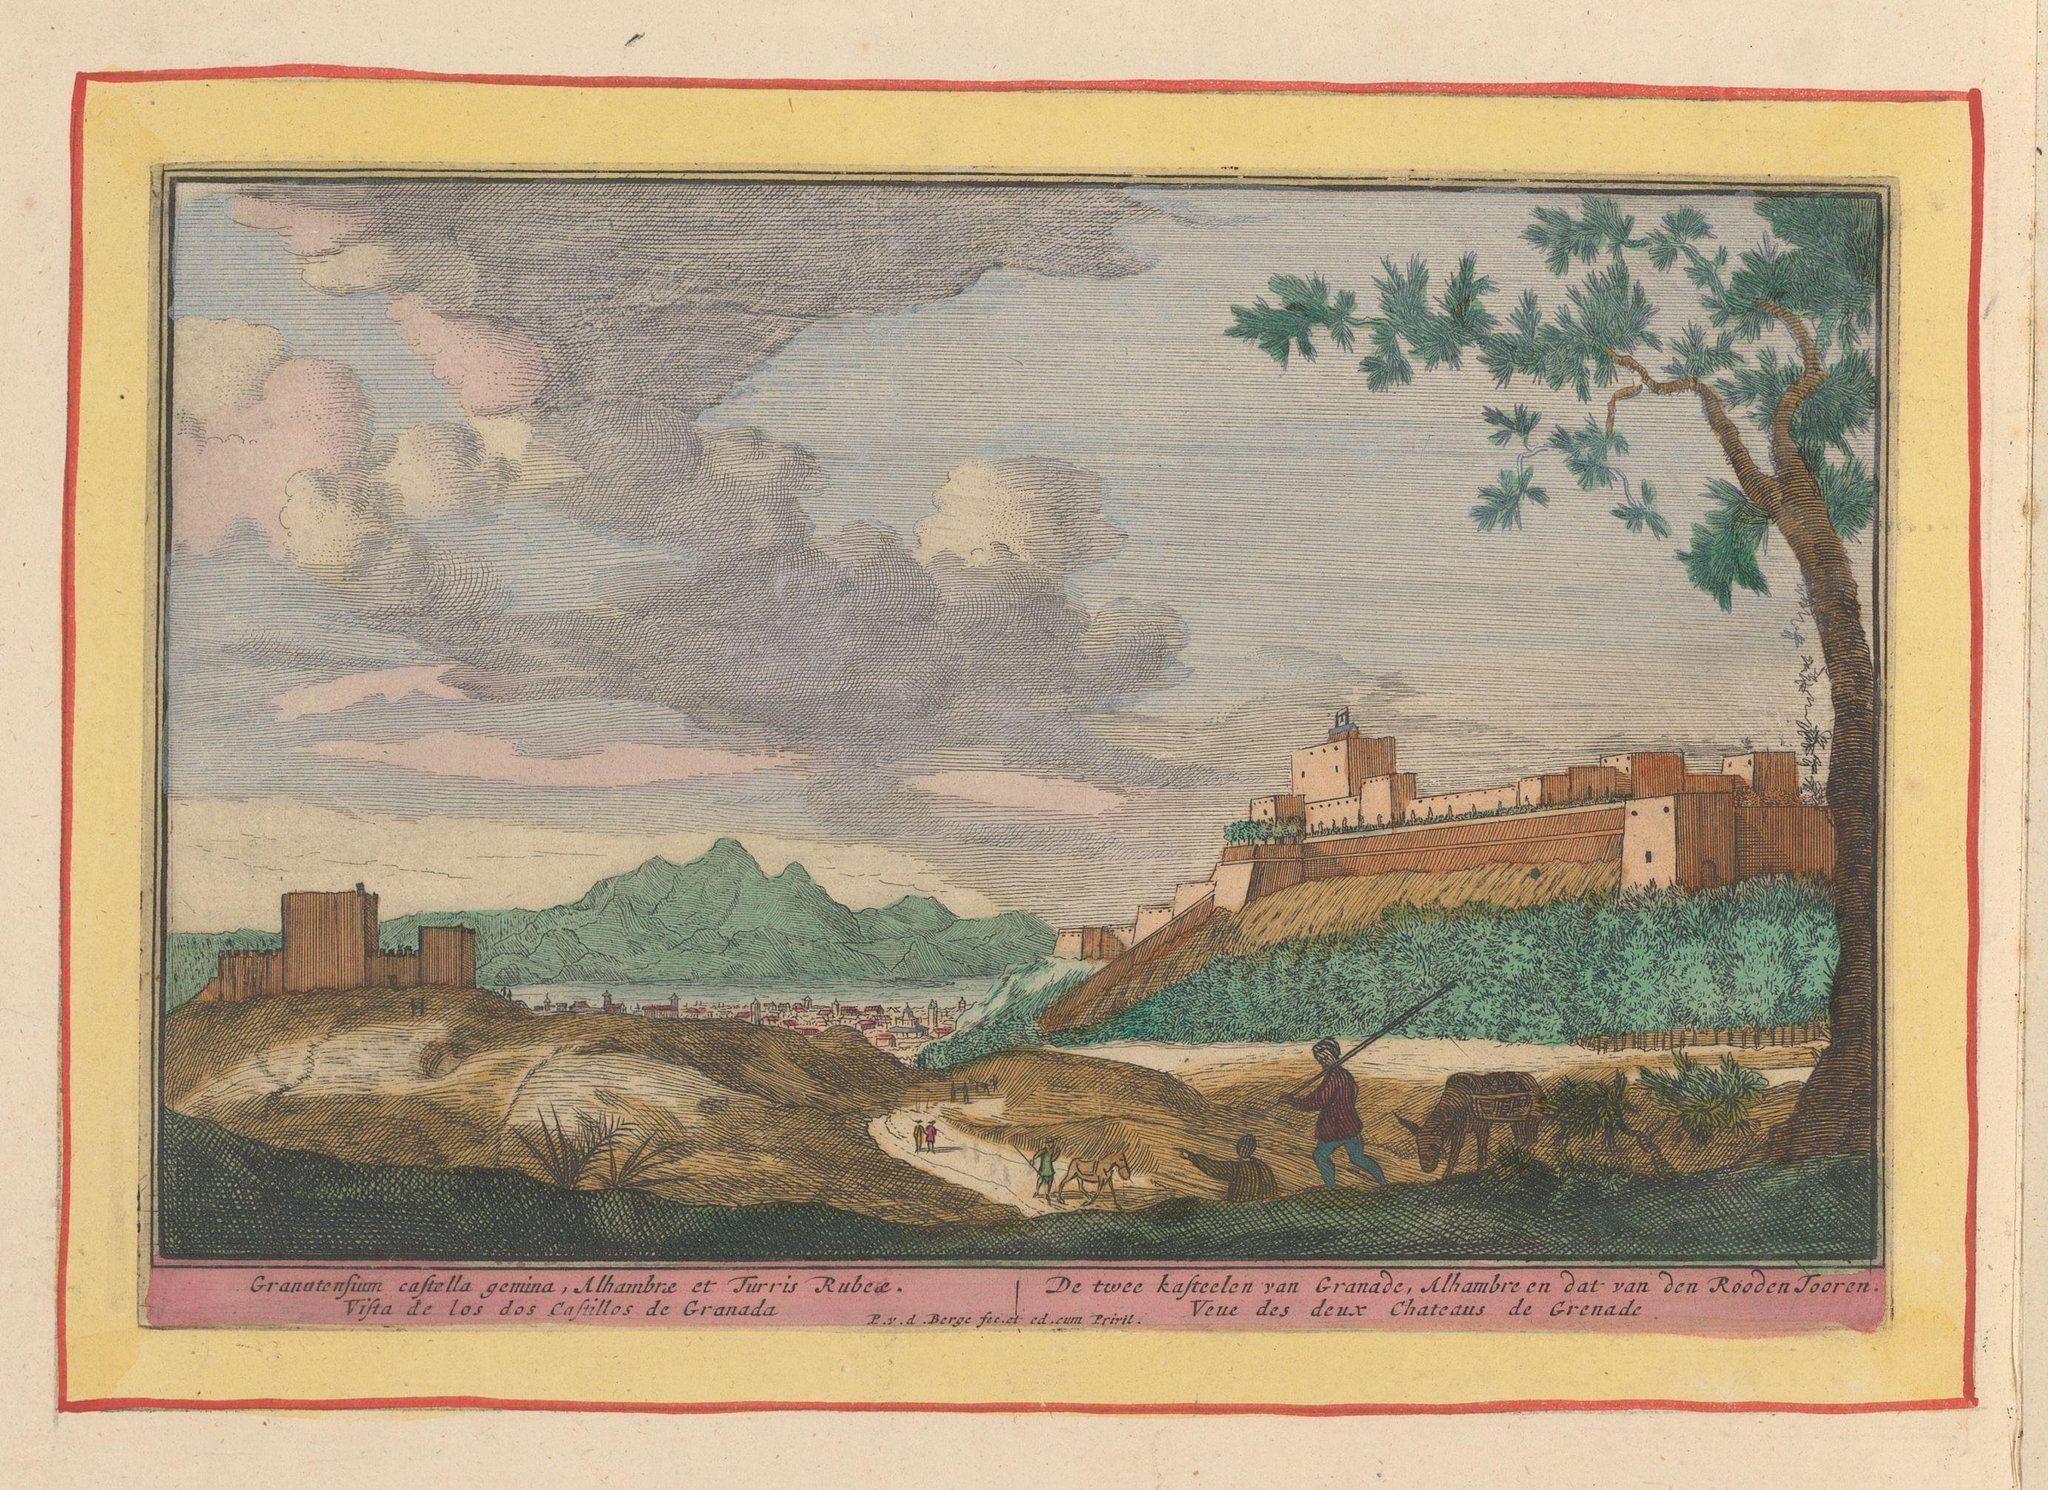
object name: print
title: De twee kasteelen van Granade, Alhambre en dat van den Rooden Tooren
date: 1694-1737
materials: paper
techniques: etching, hand coloring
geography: amsterdam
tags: fortress, mule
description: Prent uit: Theatrum Hispaniæ, exhibens regni urbes, villas ac viridaria magis illustria. Het aanmerkelykste en voortreffelykste in Spanjen (...). Amsterdam: Pieter van den Berge, ca. 1694-1737.